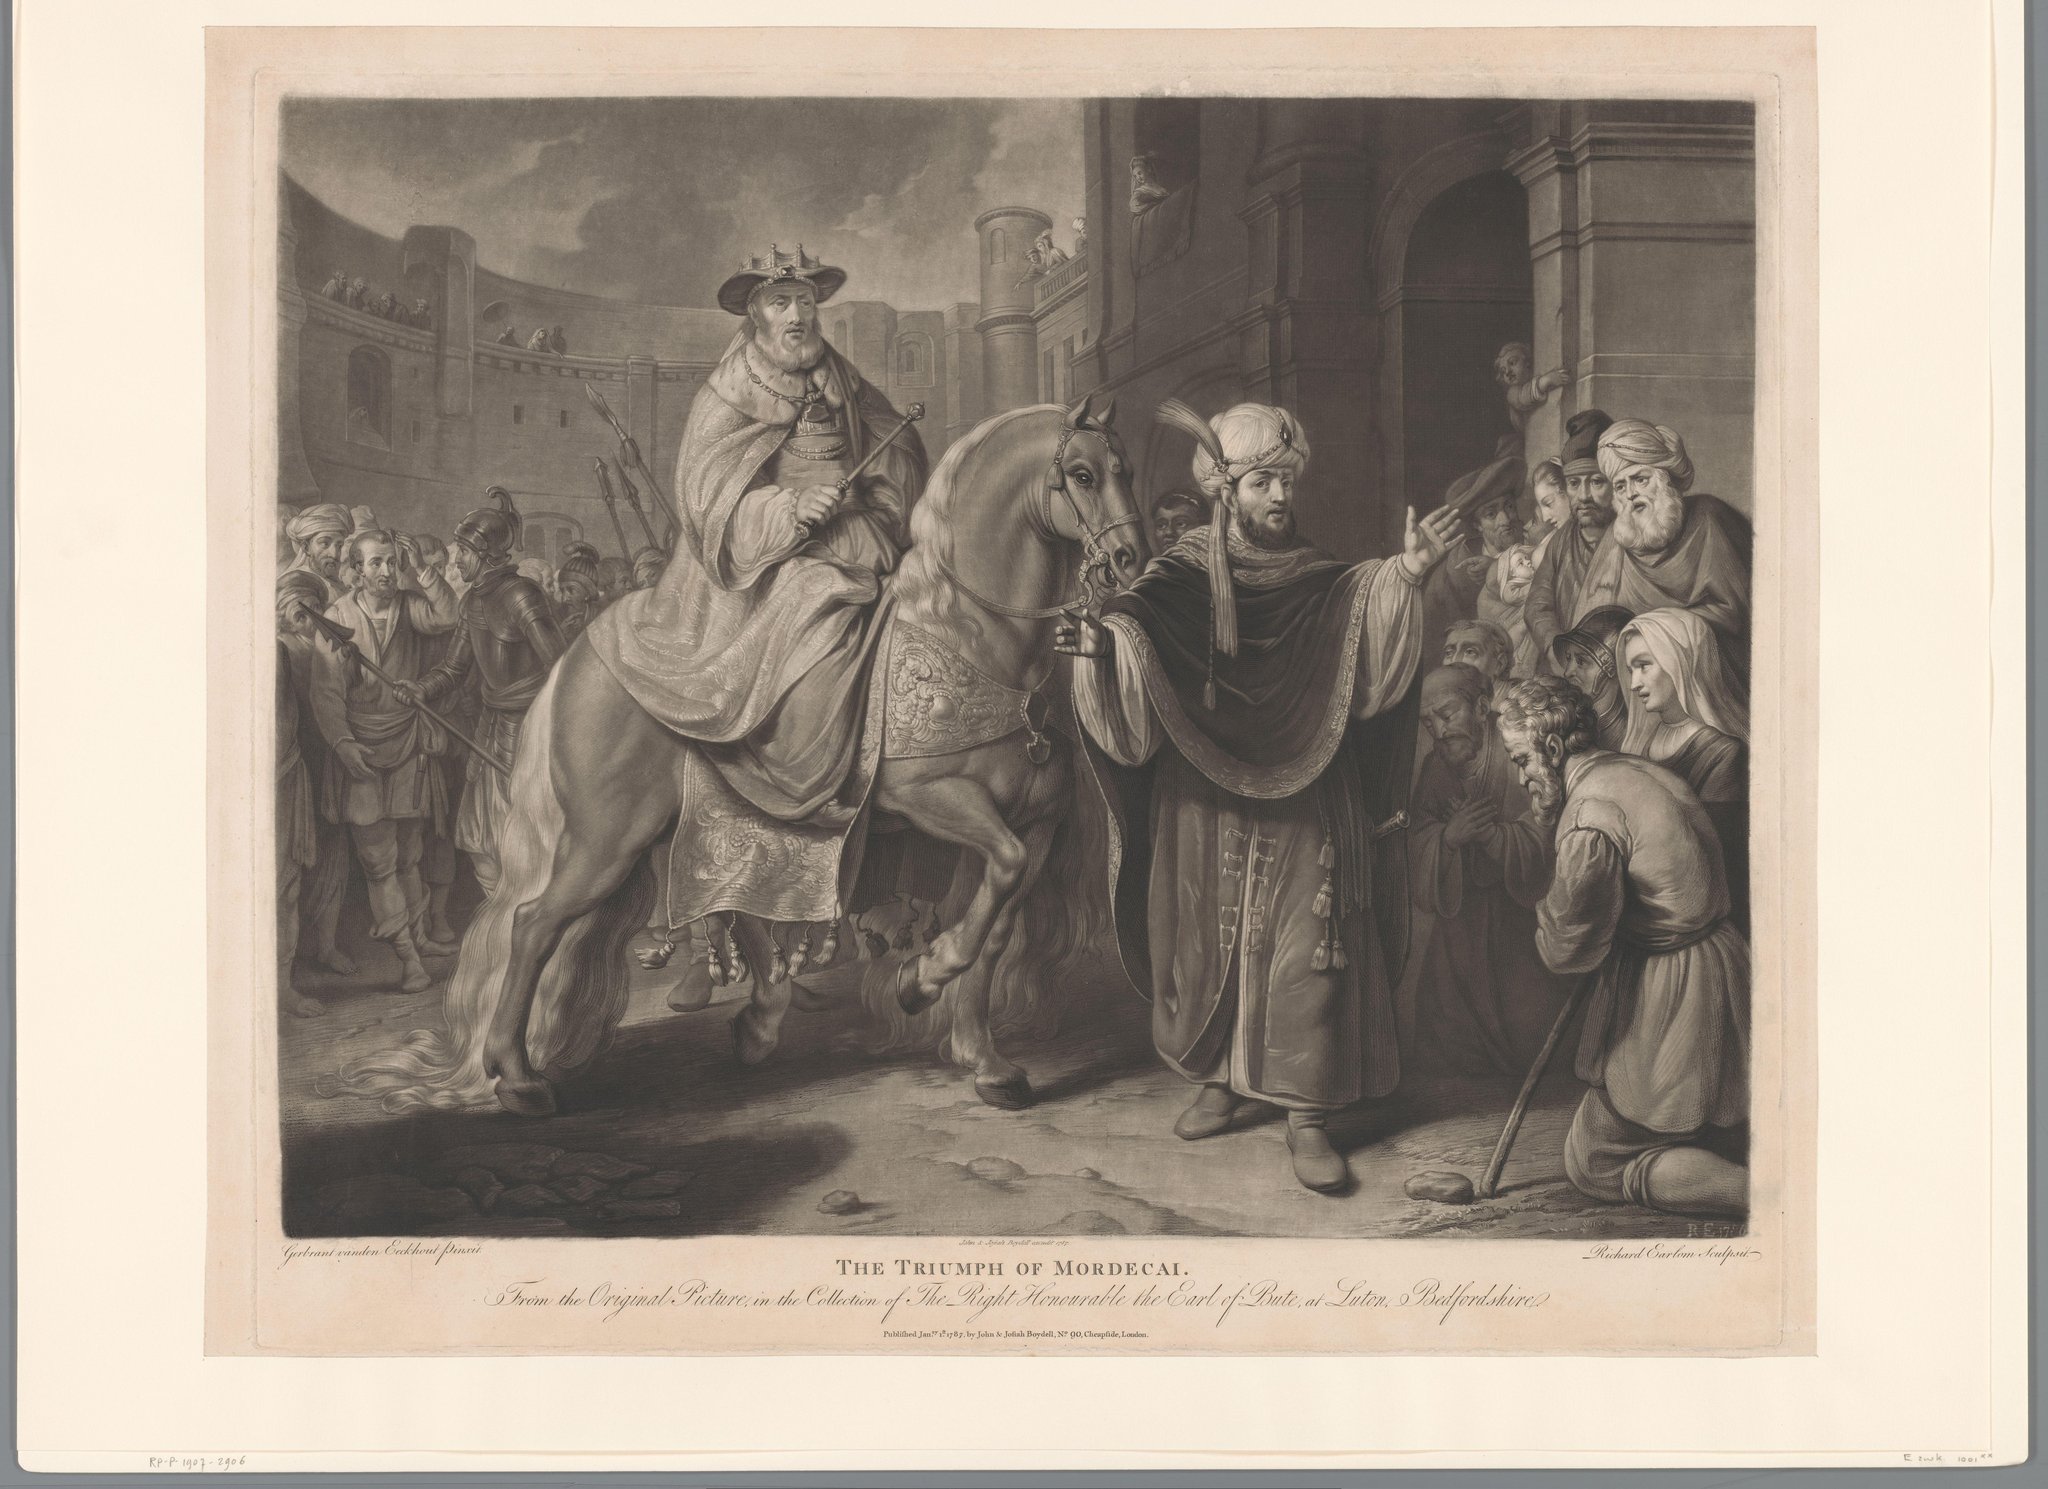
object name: print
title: Triomf van Mordechai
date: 1787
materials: paper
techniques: etching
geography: london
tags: mordecai's triumph: mordecai, mounted on the king's horse, is led through the city by haman (esther and ahasuerus may be looking on from the palace)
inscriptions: collector's mark: Lugt 2228